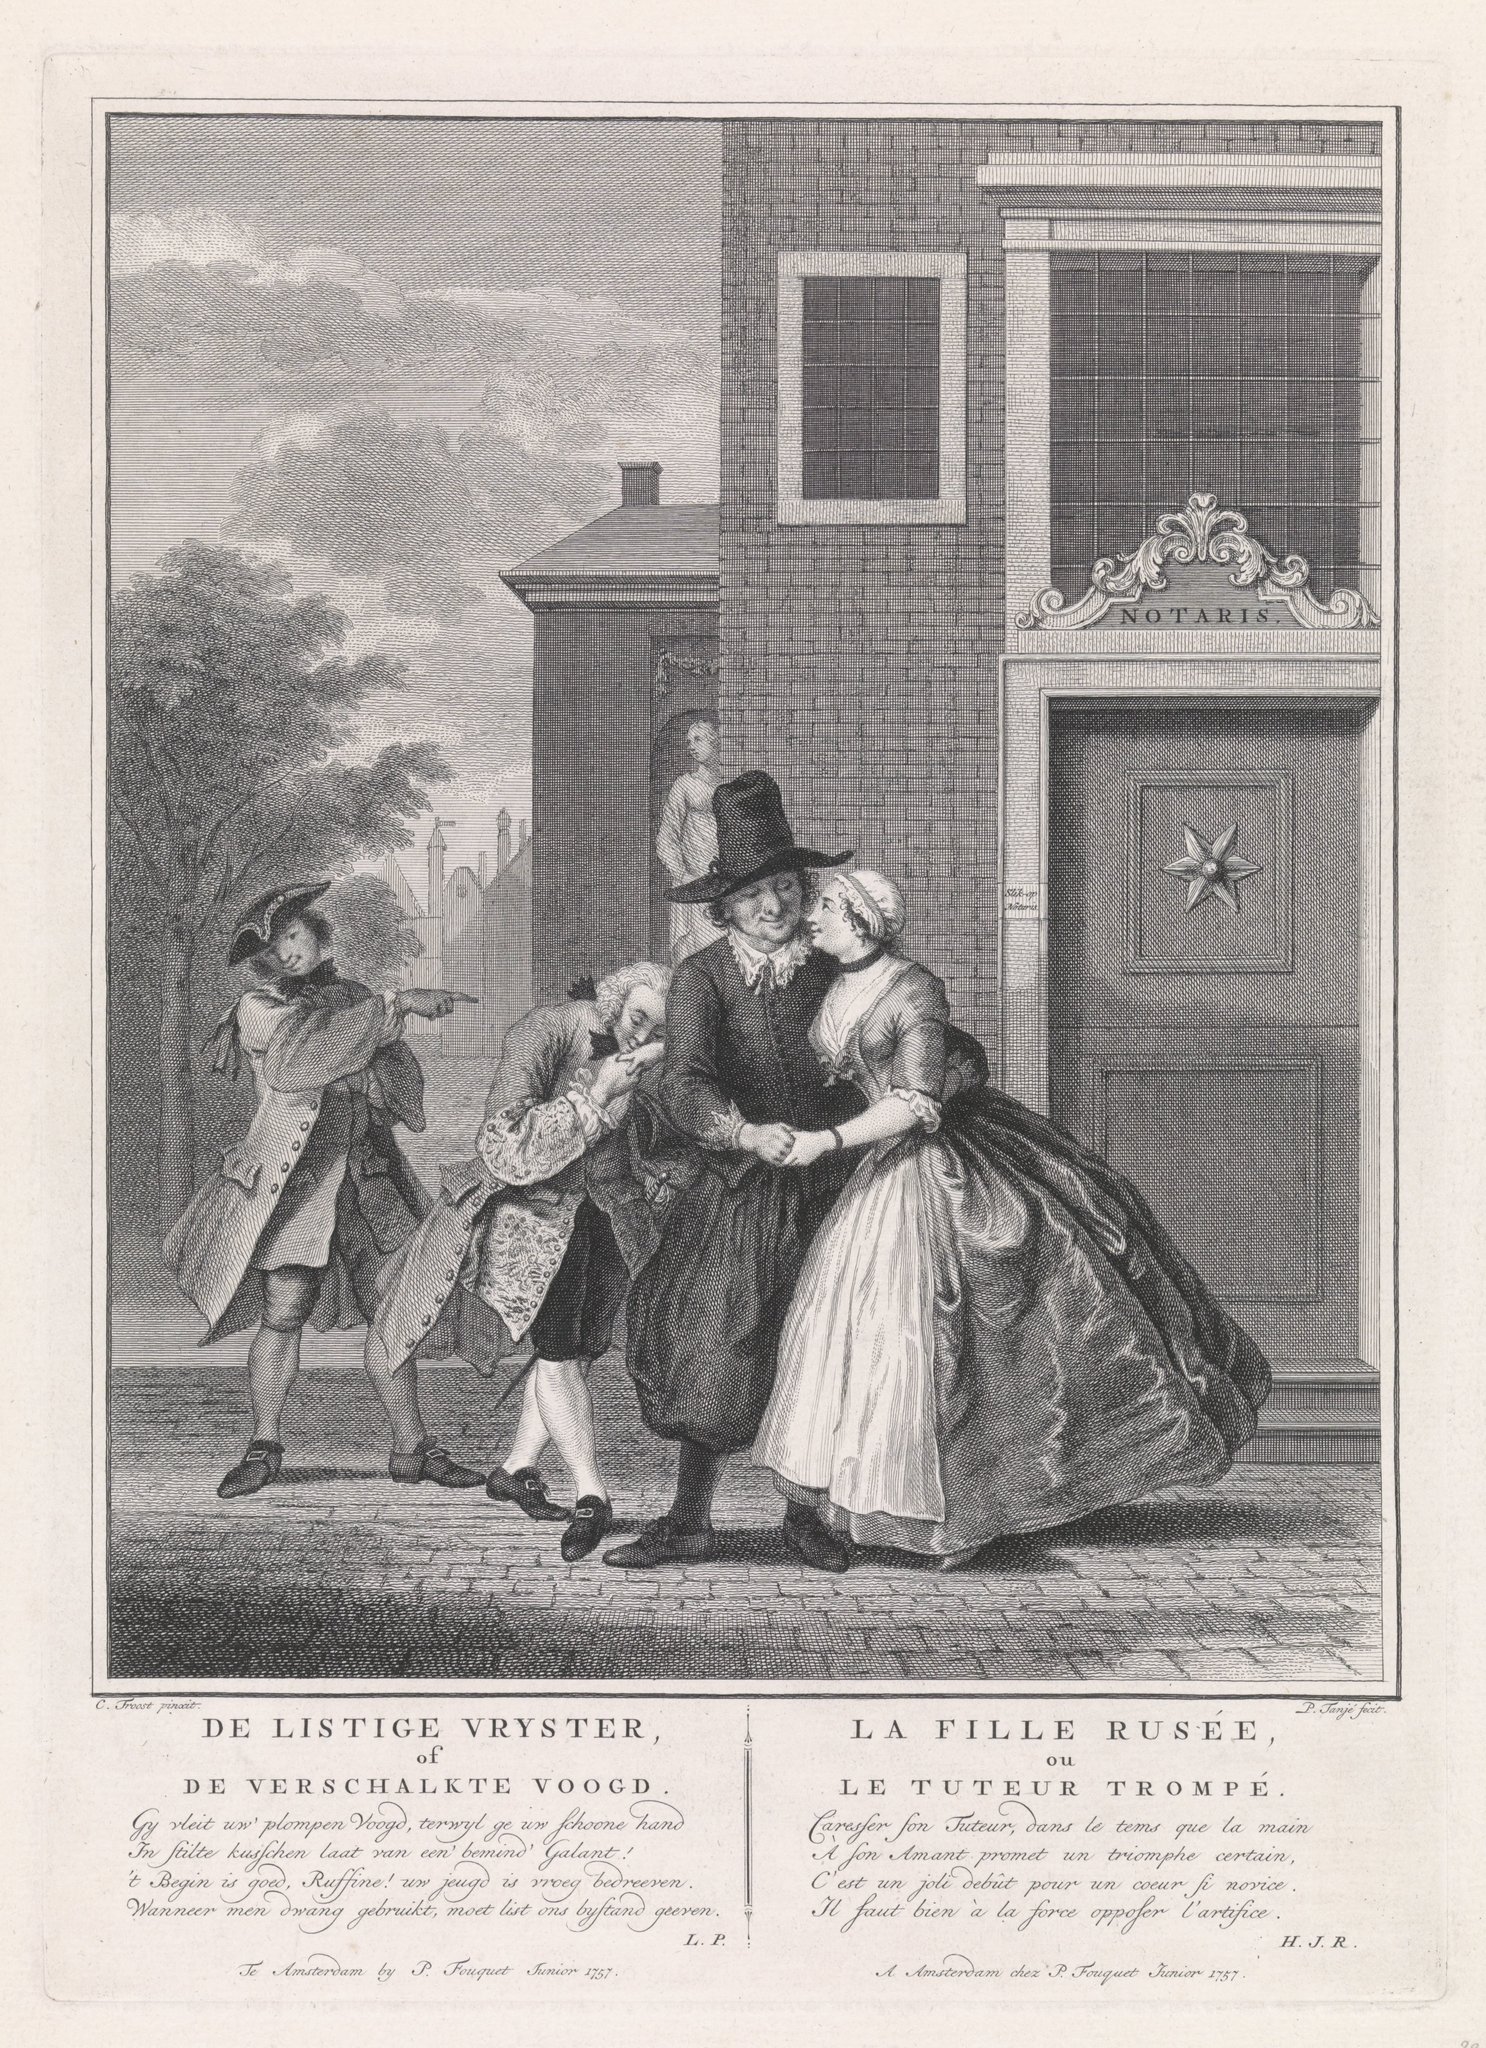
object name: print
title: De listige vryster, of de verschalkte voogd / La fille rusée ou le tuteur trompé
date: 1757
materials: paper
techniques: engraving, etching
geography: amsterdam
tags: unequal couple, ill-matched couple, kissing the hand (lovers), comedy, index finger forwards, pointing, indicating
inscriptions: collector's mark: Lugt 2228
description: Ruffina reikt haar geliefde Heerman in het geheim de rechterhand, terwijl ze haar voogd Steiloor aankijkt, met wie ze van de notaris komt. Onderaan in de marge een vierregelig vers in het Nederlands en het Frans. Scène uit het toneelstuk De listige vryster, óf de verschalkte voogd, van Ysbrand Vincent.